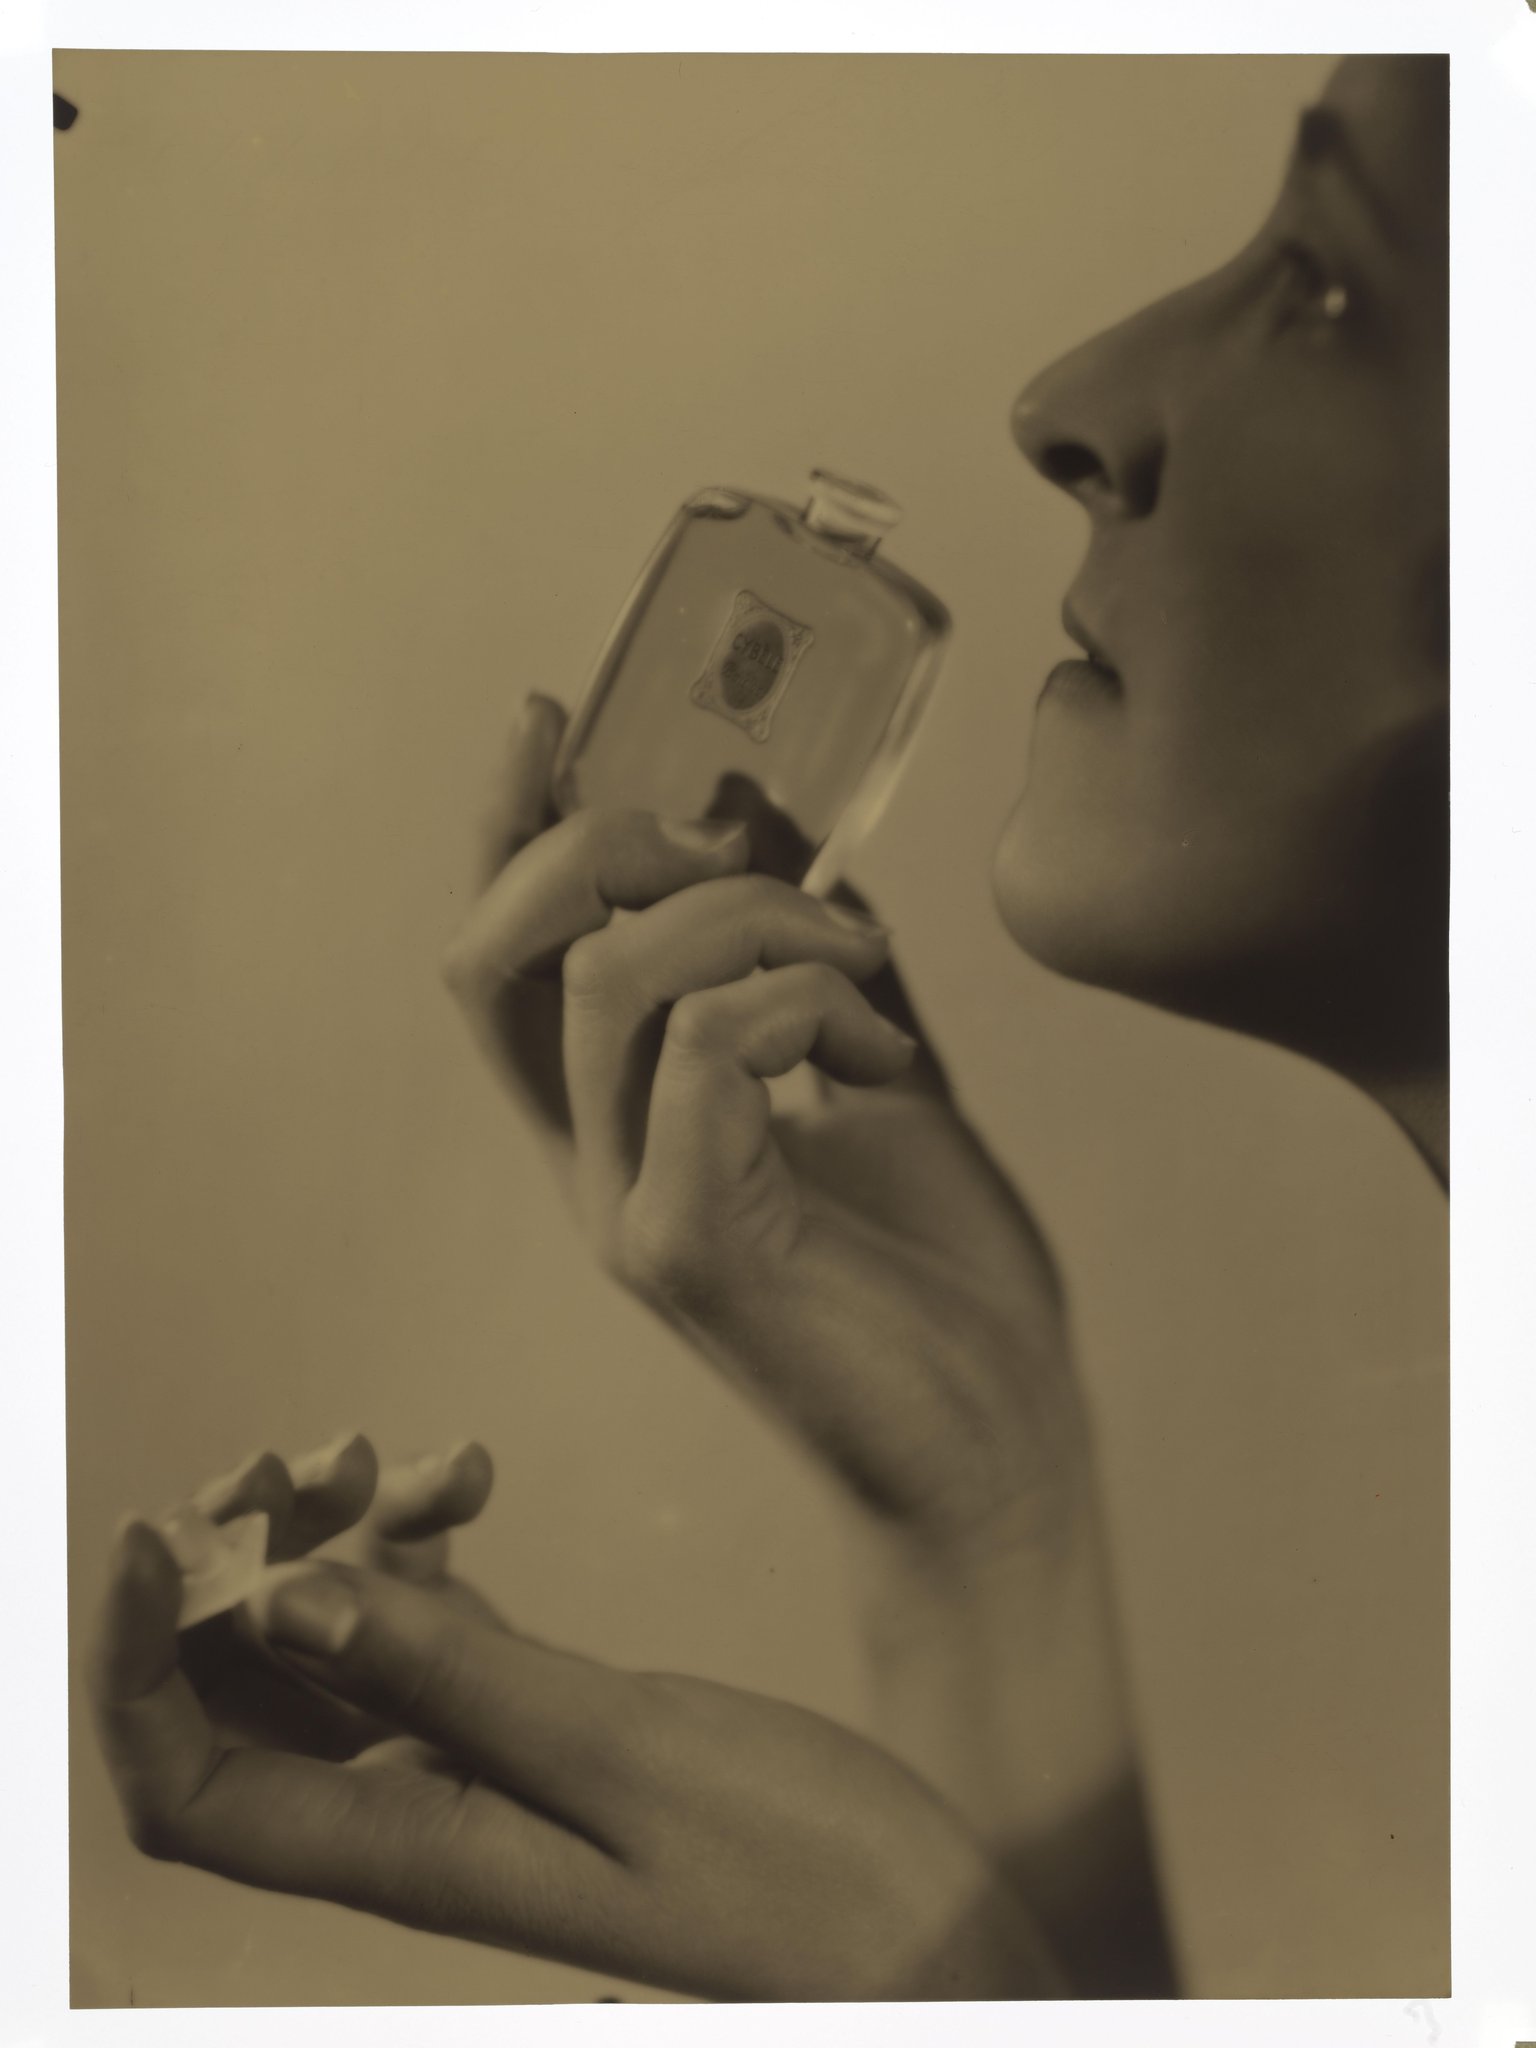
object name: advertisement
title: Reclamefoto met Mies Merkelbach als model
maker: jacob merkelbach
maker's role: fotograaf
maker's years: 1877-1942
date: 1920-1935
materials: plastic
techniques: black and white slide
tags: amsterdam, mies rosenboom-merkelbach, perfume bottle, adult woman, agreeable smell - aa - female human figure